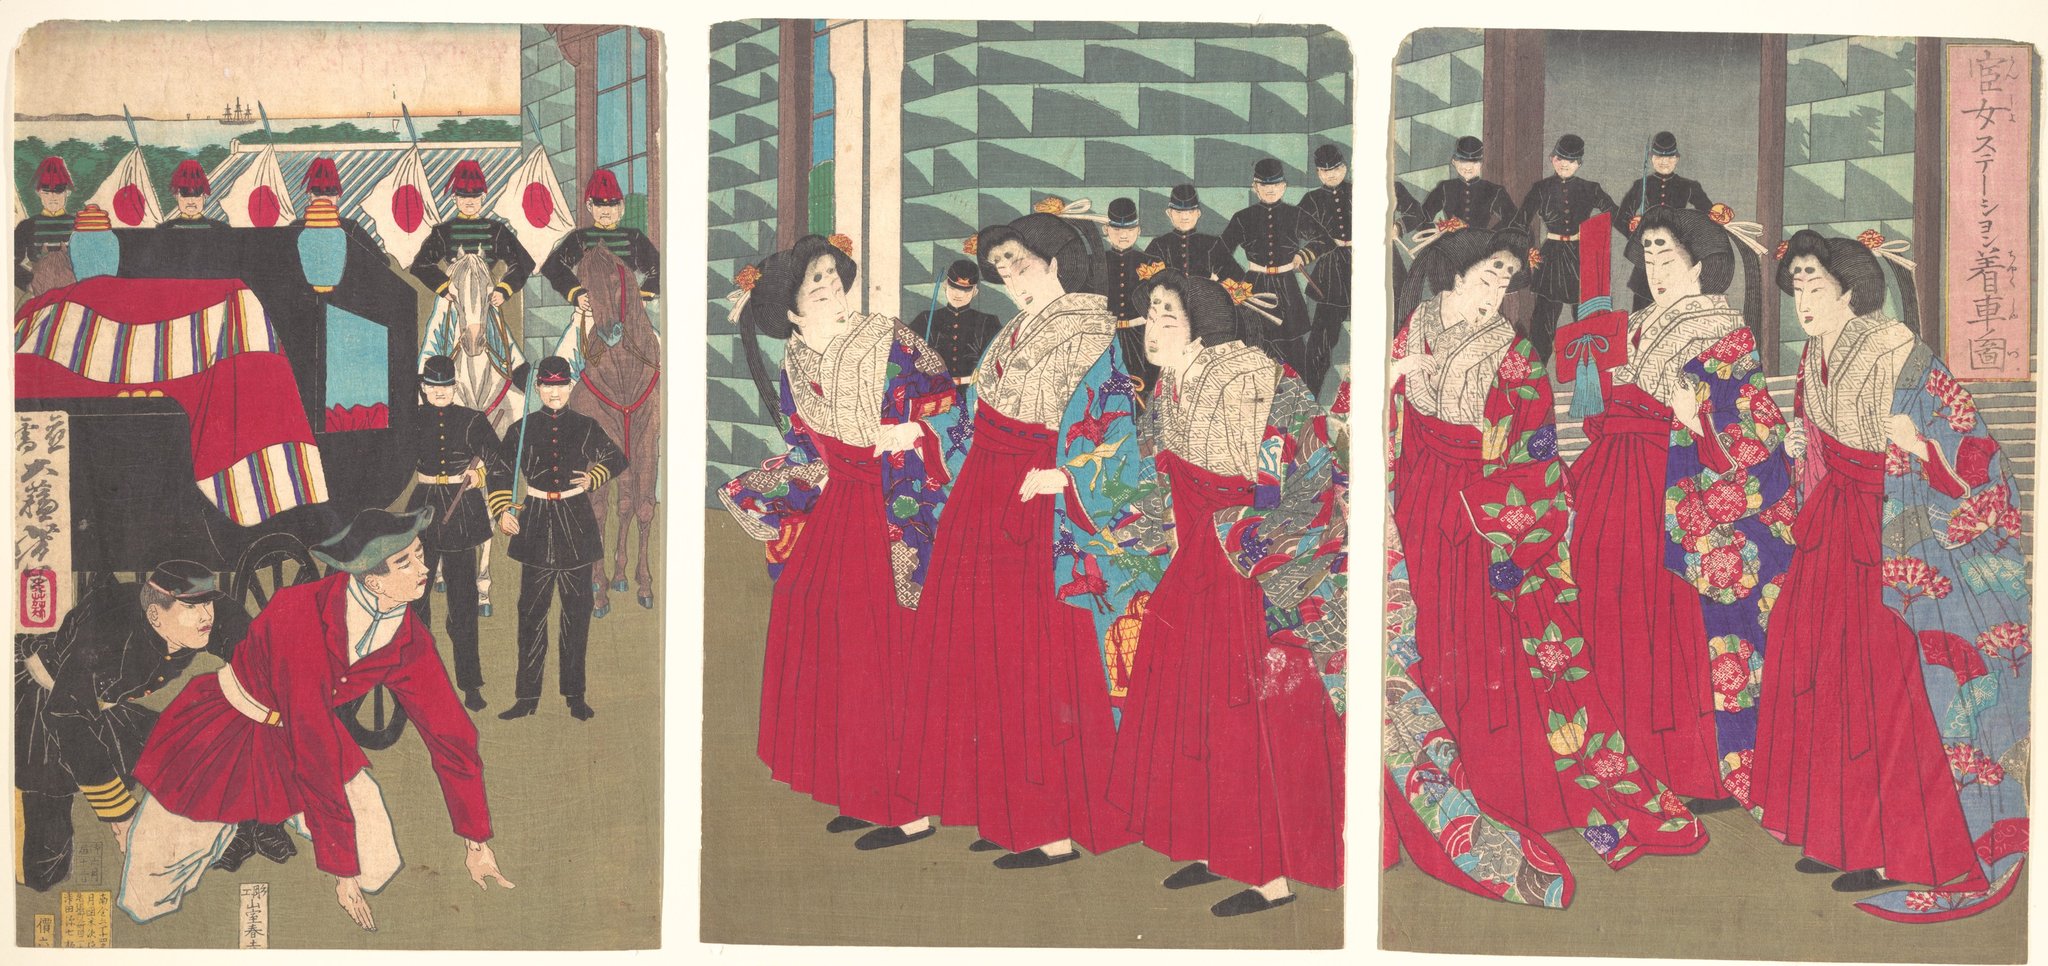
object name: print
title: Illustration of Ladies-in-waiting boarding at a station (Kanjo sutēshon chakusha zu)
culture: japanese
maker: tsukioka yoshitoshi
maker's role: artist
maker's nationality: japanese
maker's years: 1839-1892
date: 1879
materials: ink, paper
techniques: woodblock print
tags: men,women